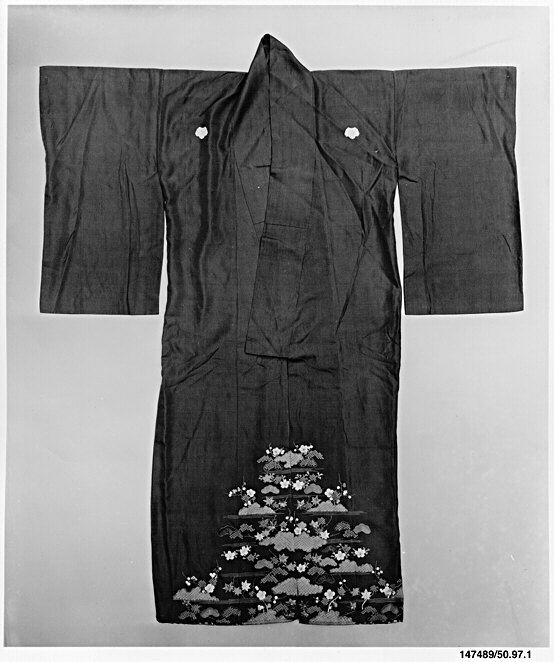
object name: woman's kimono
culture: japanese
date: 1801-1900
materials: silk